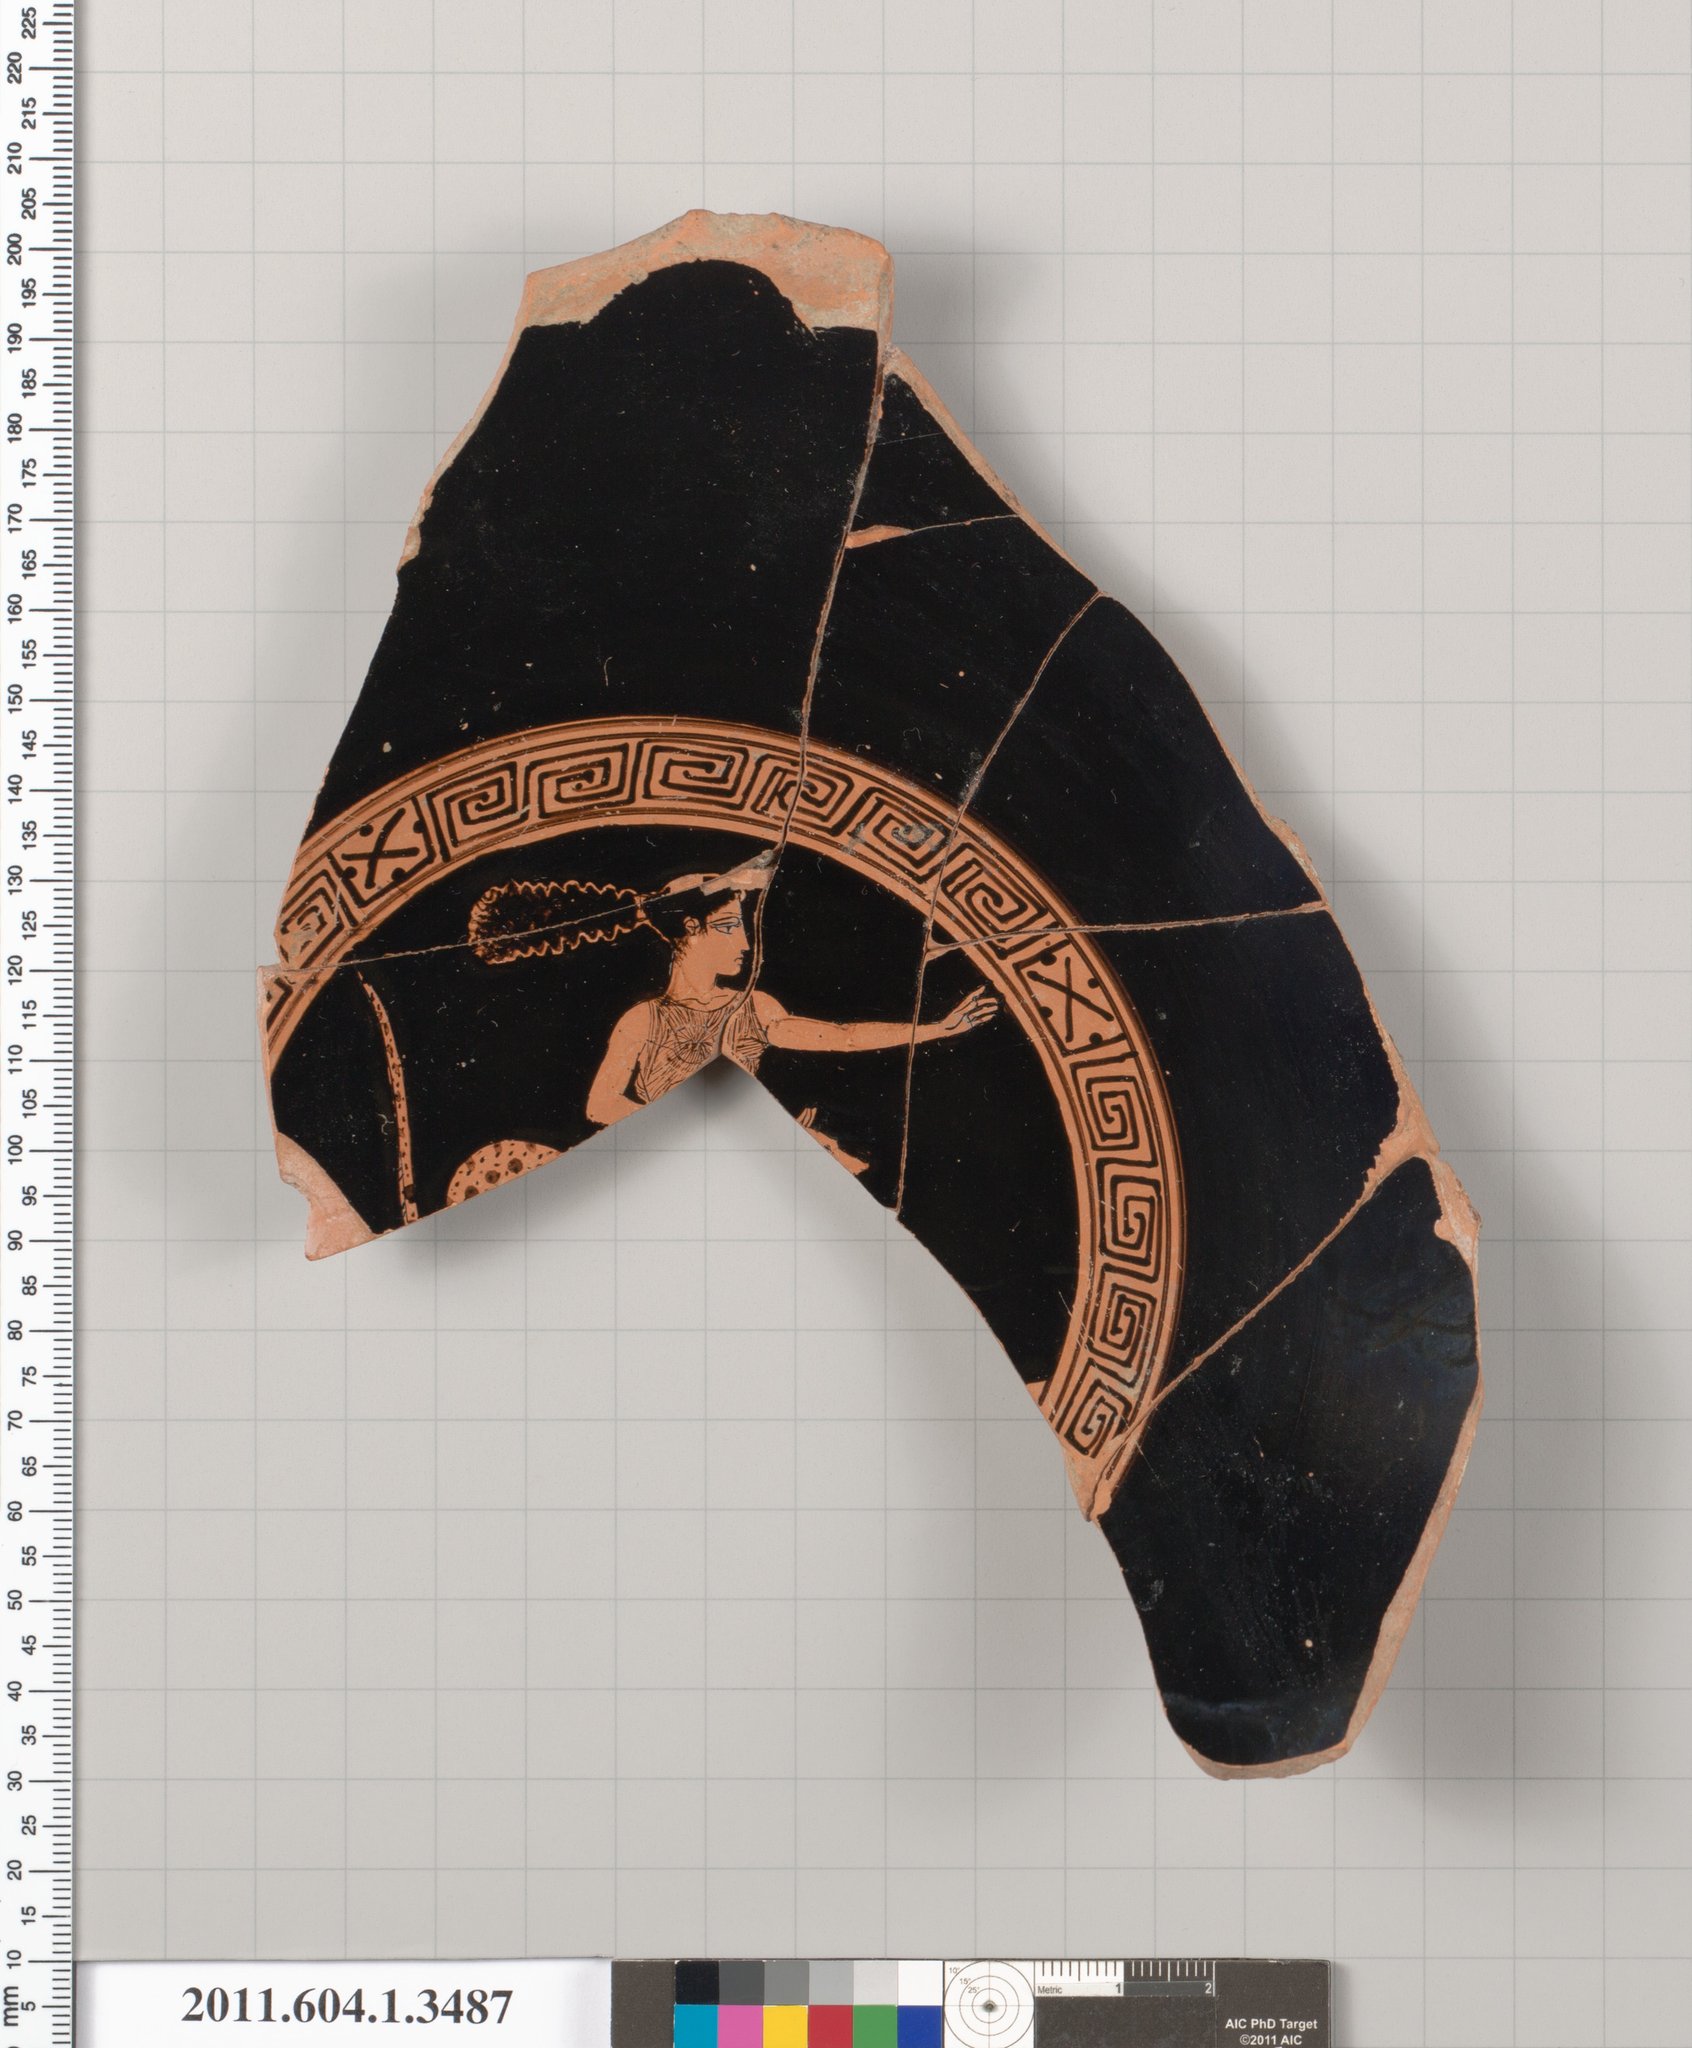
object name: kylix fragment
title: Terracotta fragment of a kylix (drinking cup)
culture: greek, attic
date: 475-451 BCE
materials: terracotta